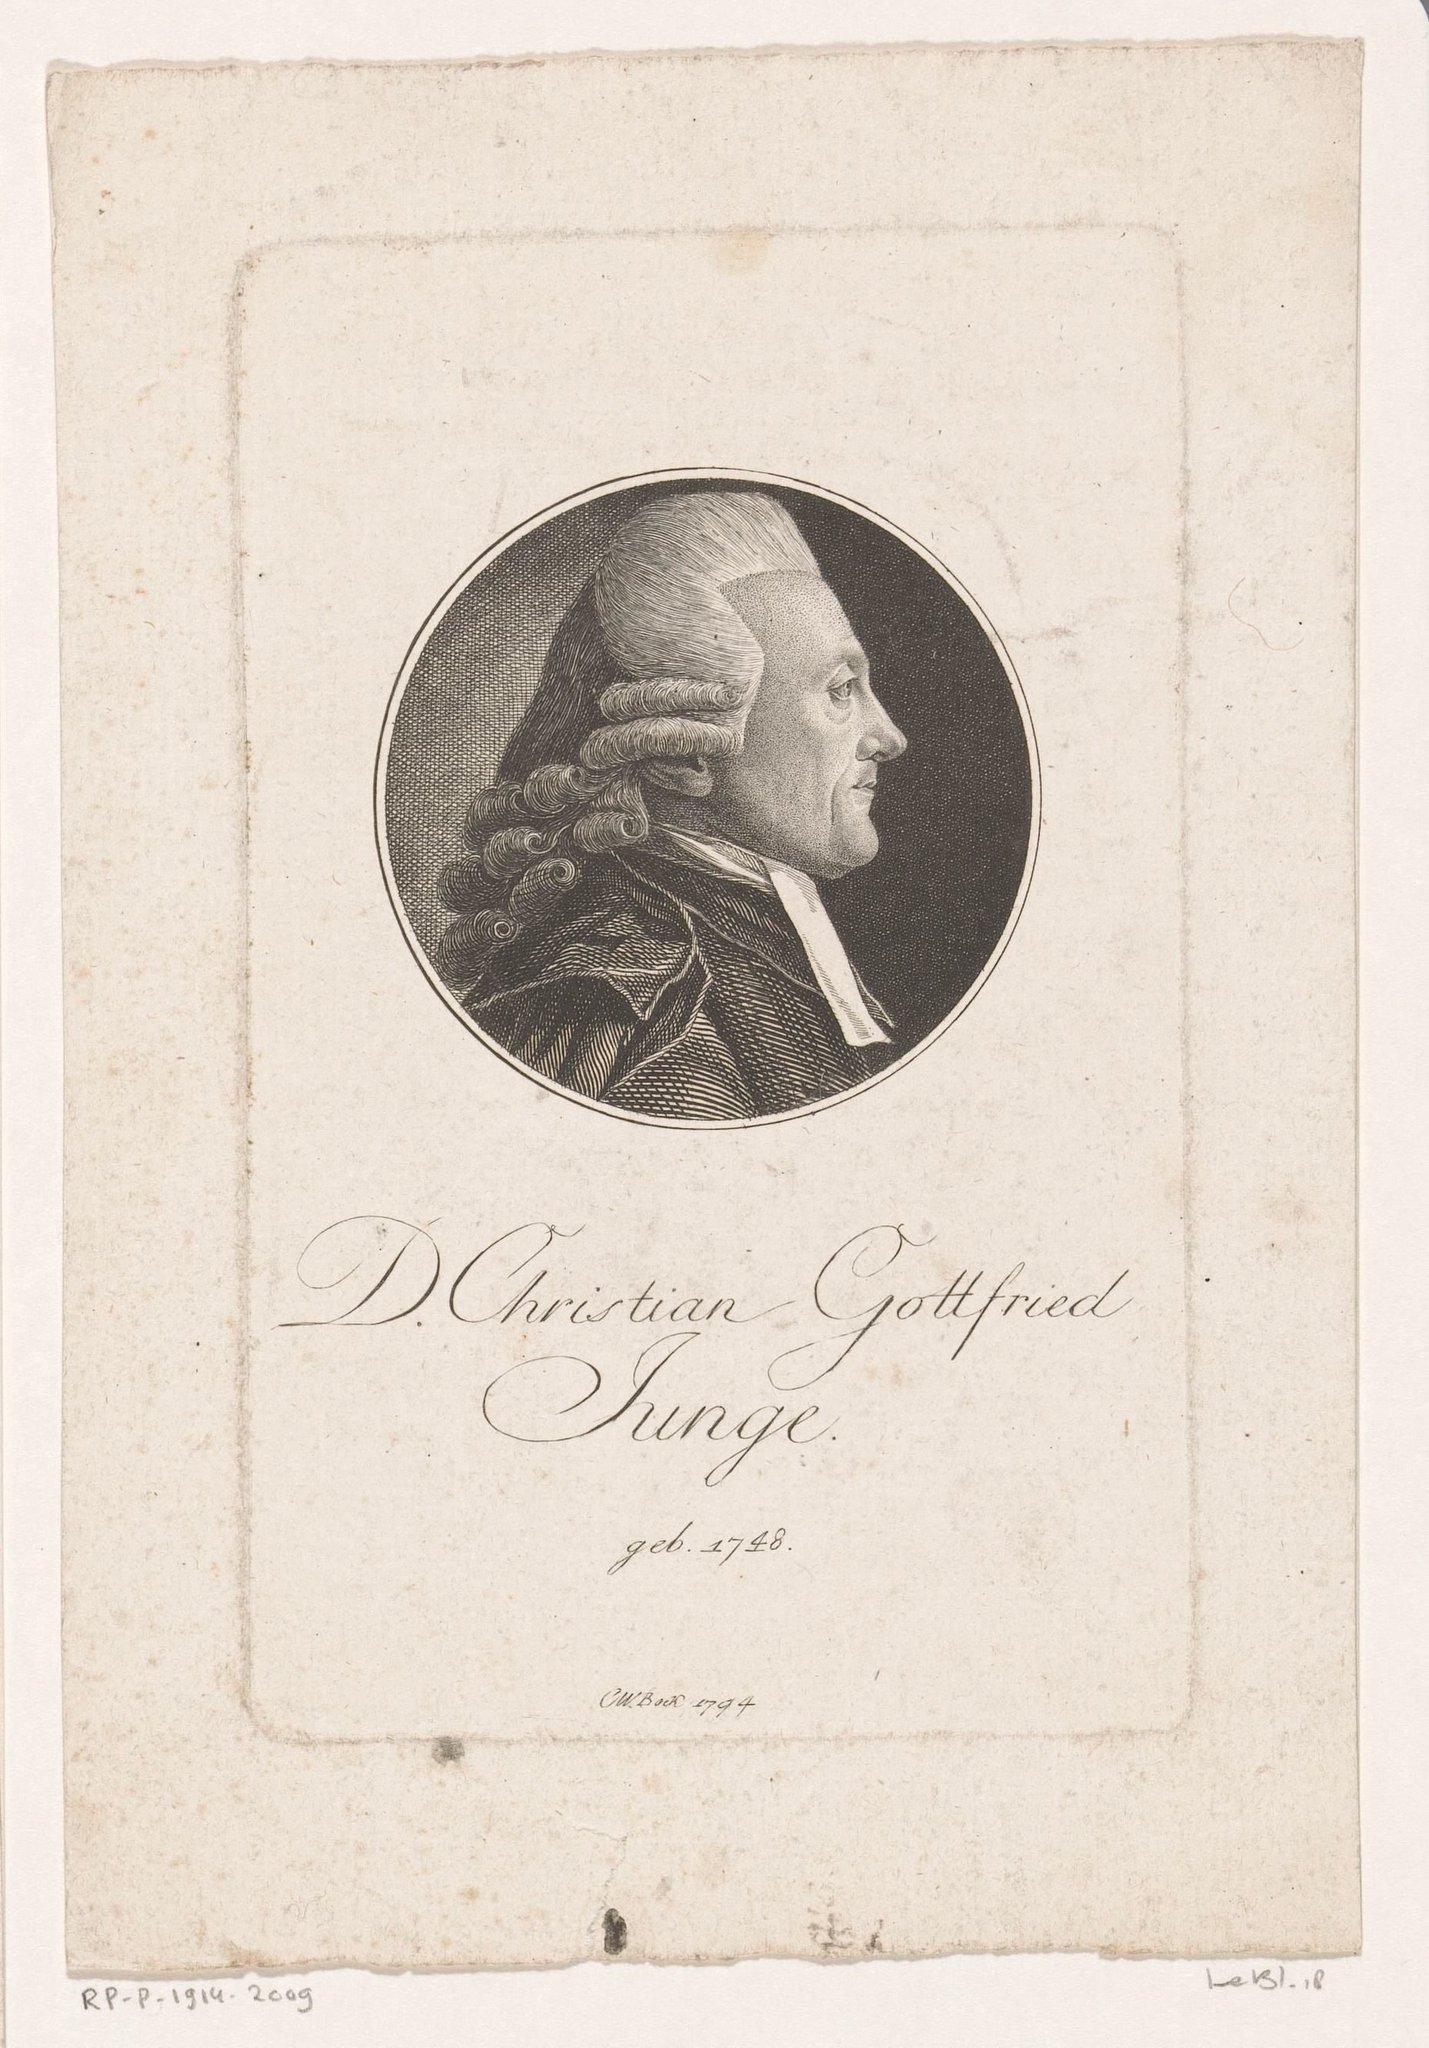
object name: print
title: Portret van Christian Gottfried Junge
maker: christoph wilhelm bock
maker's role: print maker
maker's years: 1755-1836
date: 1794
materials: paper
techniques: engraving, etching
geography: nuremberg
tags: historical persons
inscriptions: collector's mark: Lugt 2228